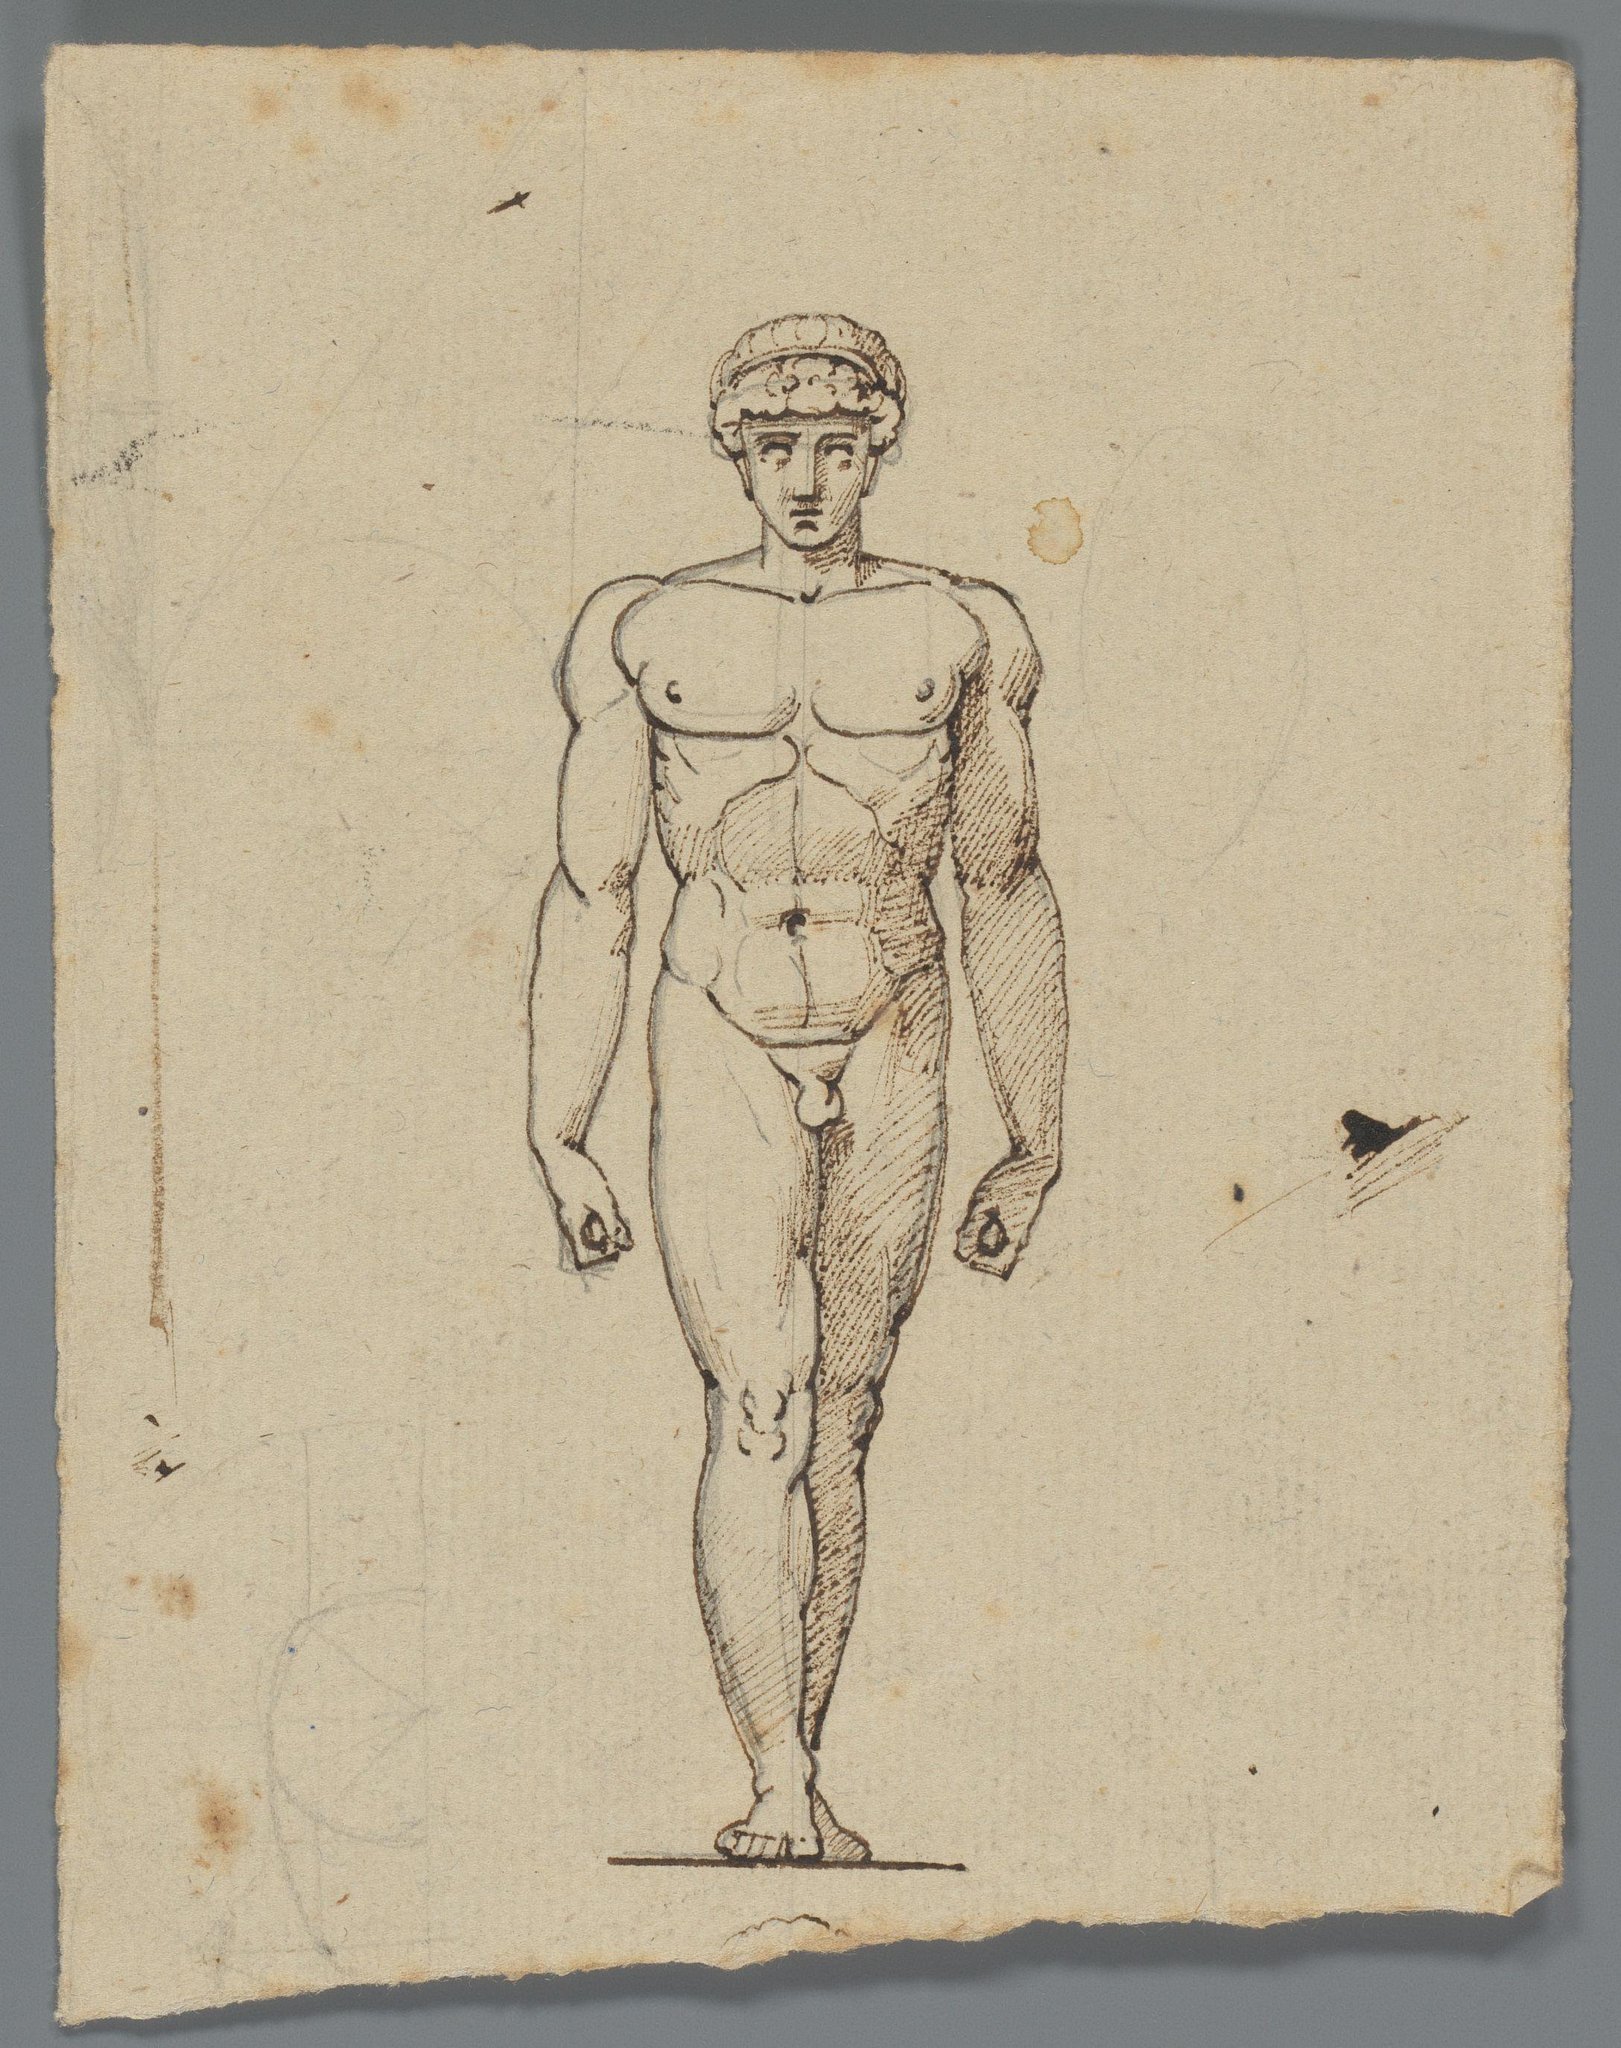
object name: drawing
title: Gespierde man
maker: jacobus everhardus josephus van den berg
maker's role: draughtsman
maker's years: 1802-1861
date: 1812-1861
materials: ink, paper, pencil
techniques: pen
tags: the (nude) human figure; 'corpo humano' (ripa)